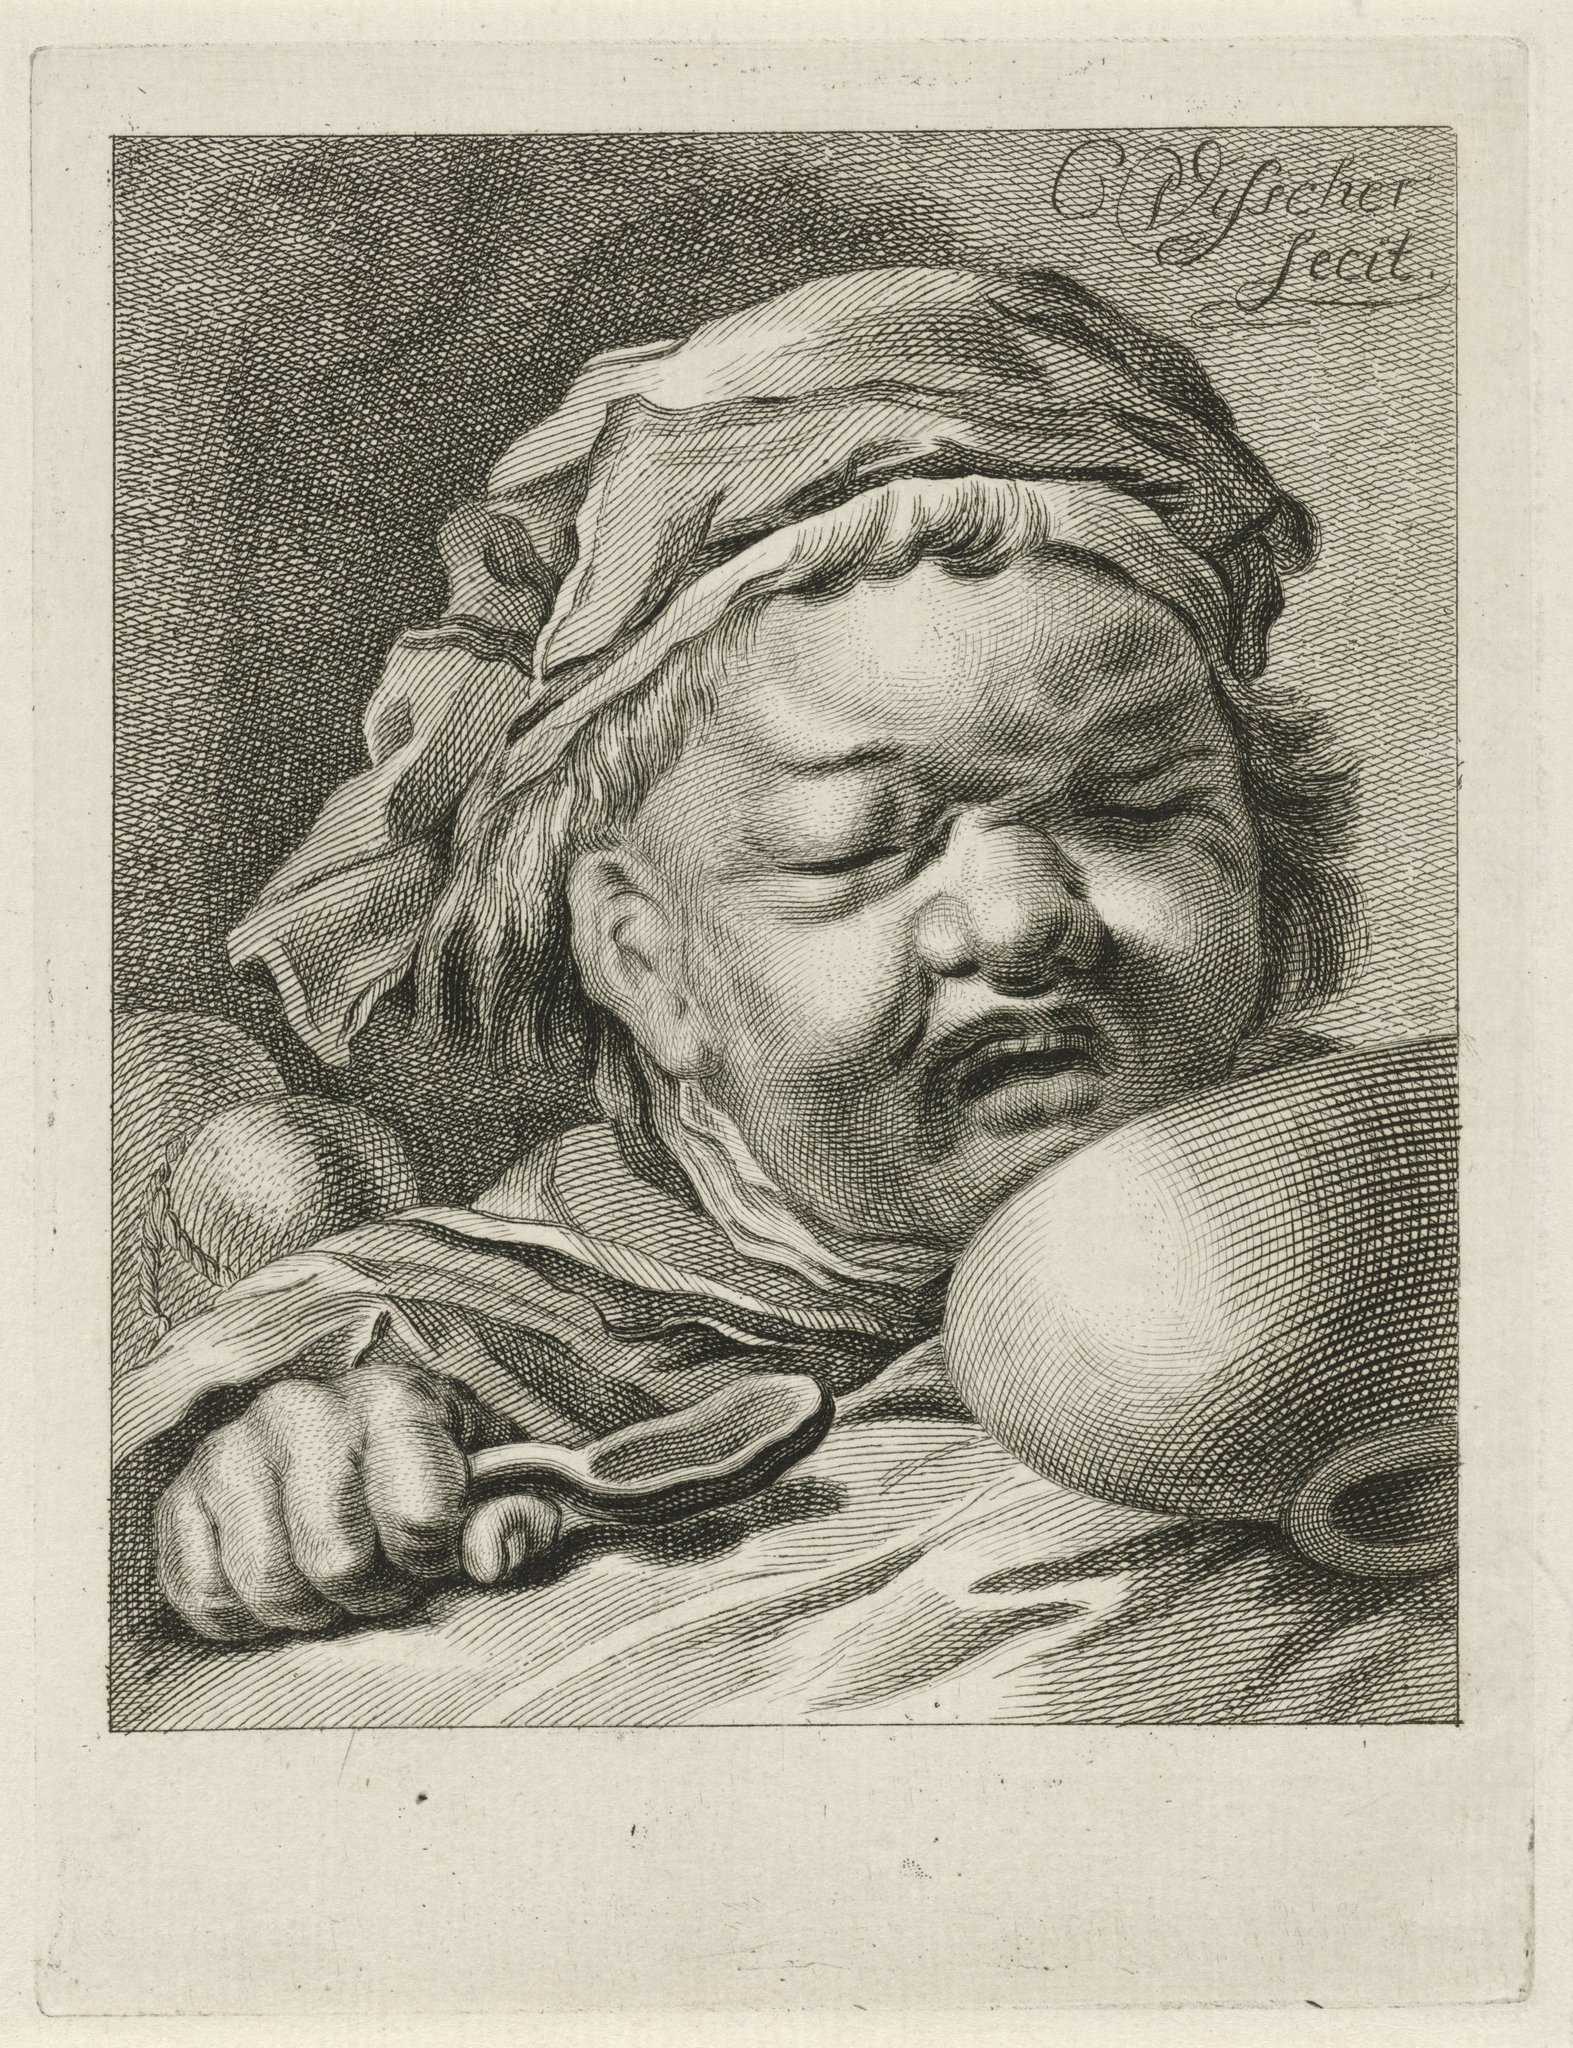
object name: print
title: Huilend kind met nap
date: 1768-1796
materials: paper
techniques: engraving, etching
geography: leiden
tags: spoon, bowl, tot, toddler ~ the ages of man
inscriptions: collector's mark: Lugt 240